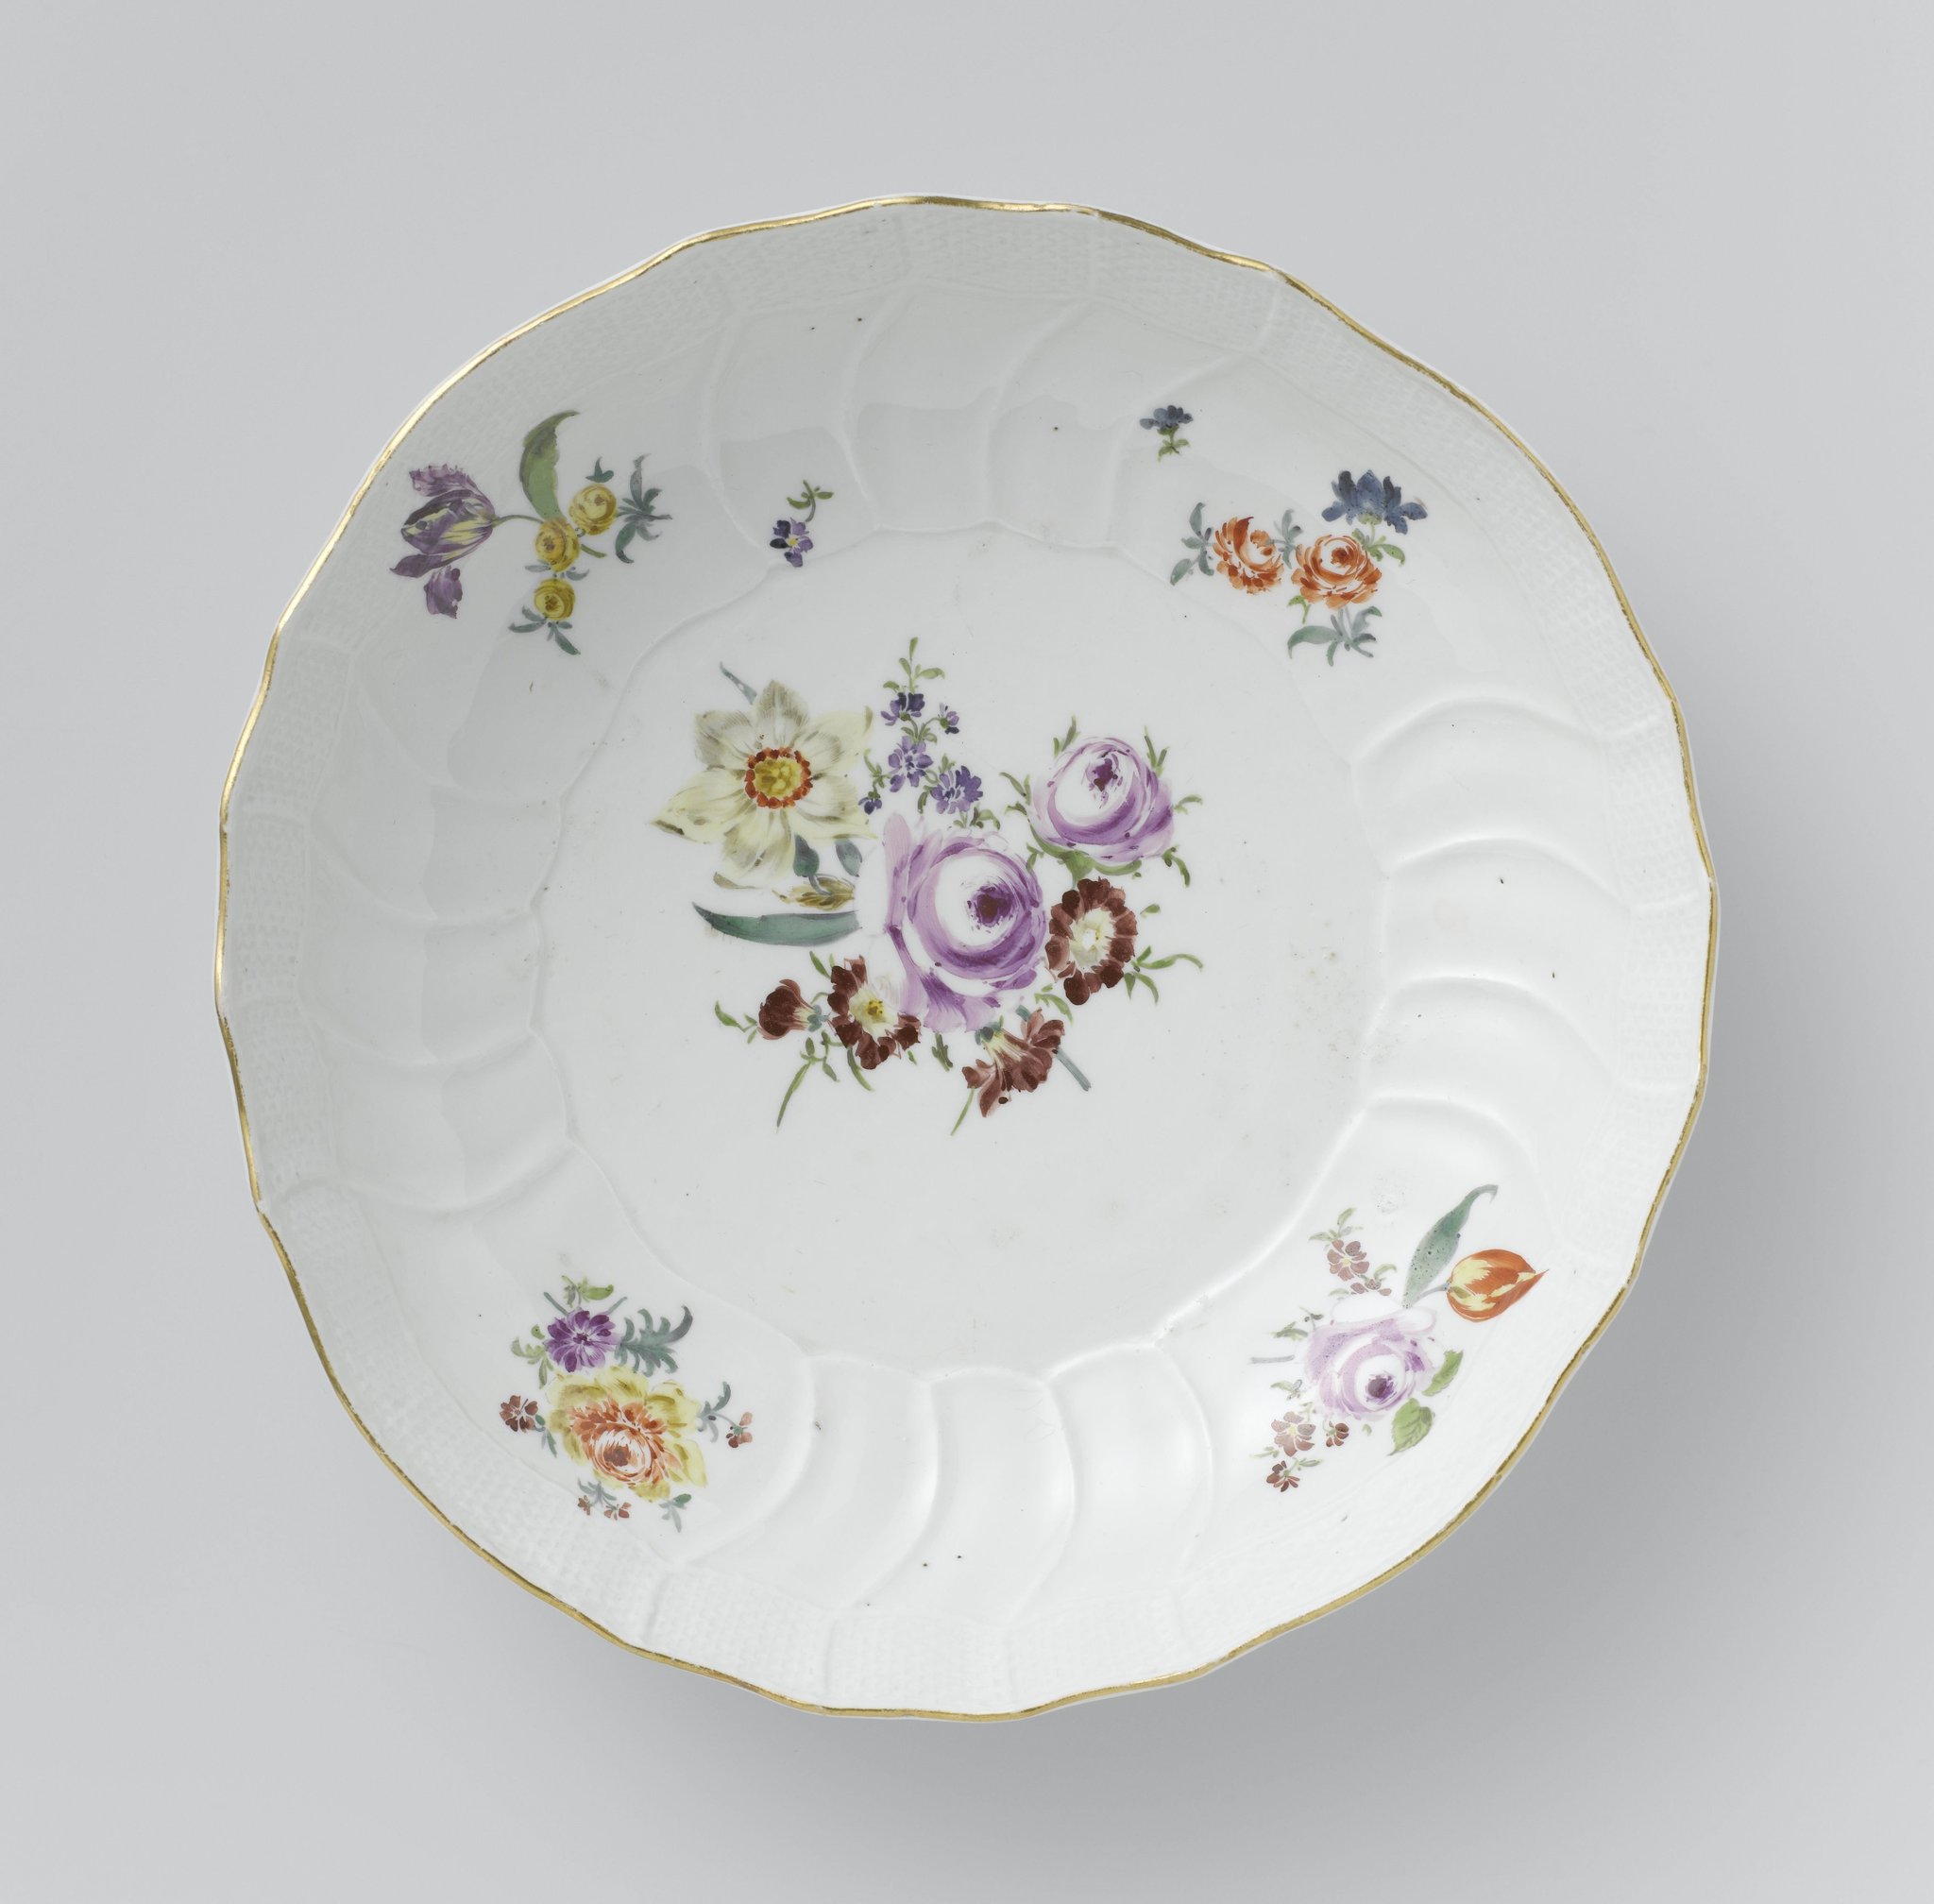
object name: platter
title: Schotel, veelkleurig beschilderd met Deutsche Blumen, insekten en vruchten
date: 1750-1760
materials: porcelain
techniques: painted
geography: meissen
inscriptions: factory mark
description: Ronde schotel van beschilderd porselein. De schotel is beschilderd met Deutsche Blumen, insekten en vruchten. De rand is in reliëf versierd met het Neuozier-patroon. De schotel is gemerkt en hoort bij een servies (BK-17474-1 t/m BK-17474-253).